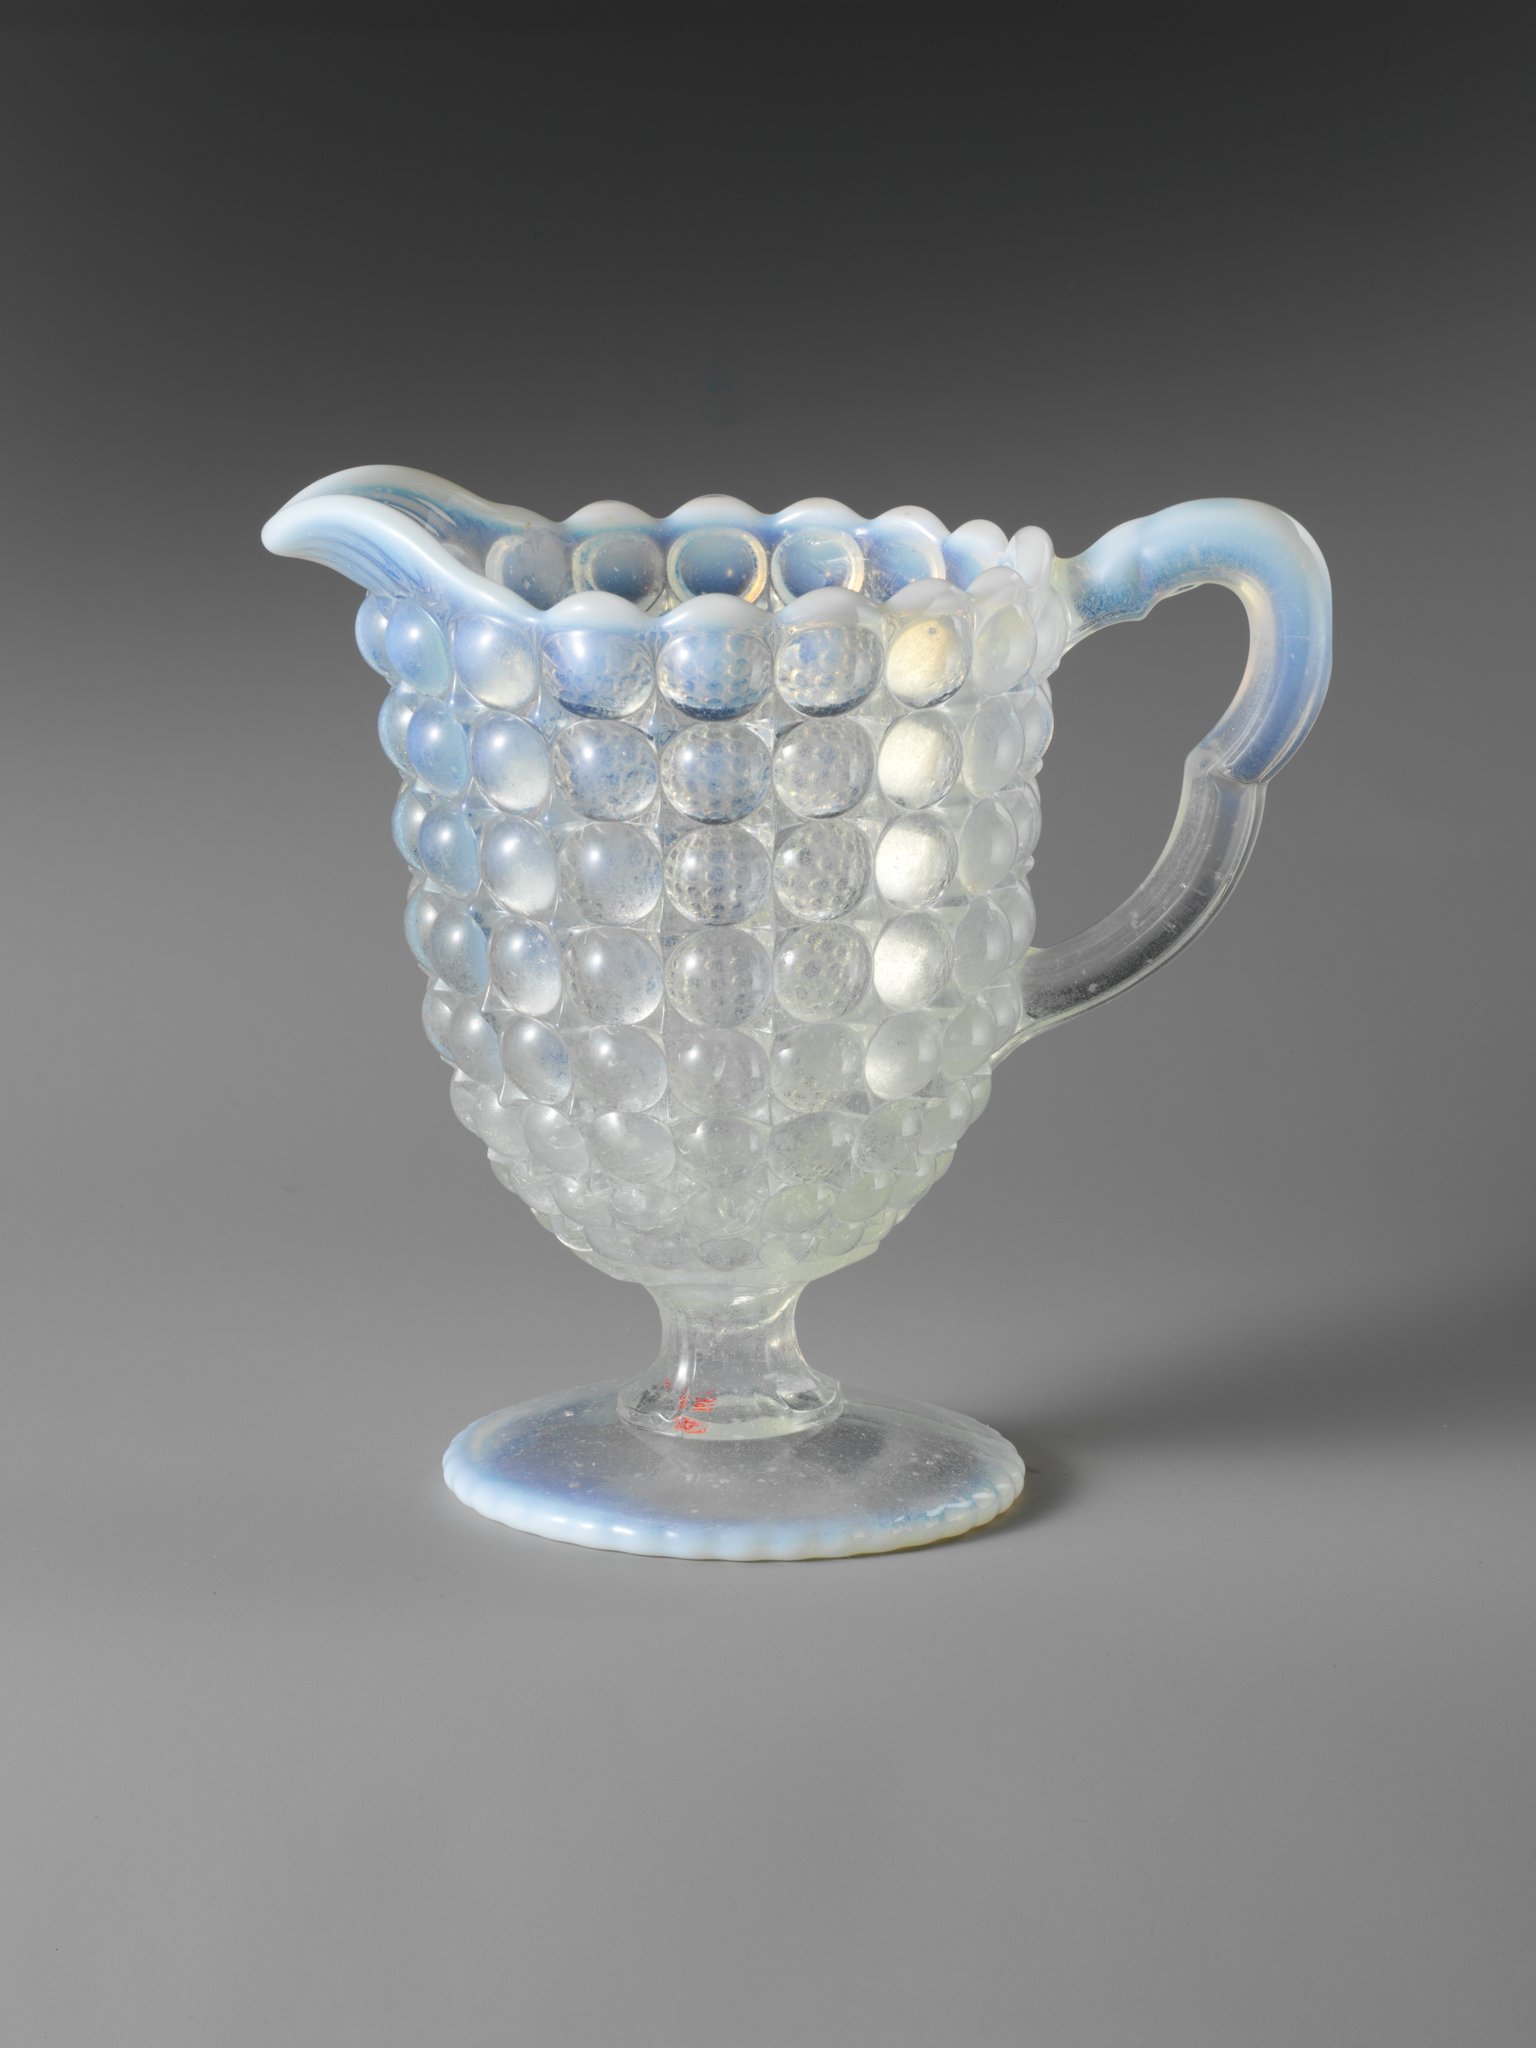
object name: cream pot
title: Creamer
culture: american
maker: richards and hartley flint glass co.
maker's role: maker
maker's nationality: american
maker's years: 1867-1890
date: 1888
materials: glass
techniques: pressed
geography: united states